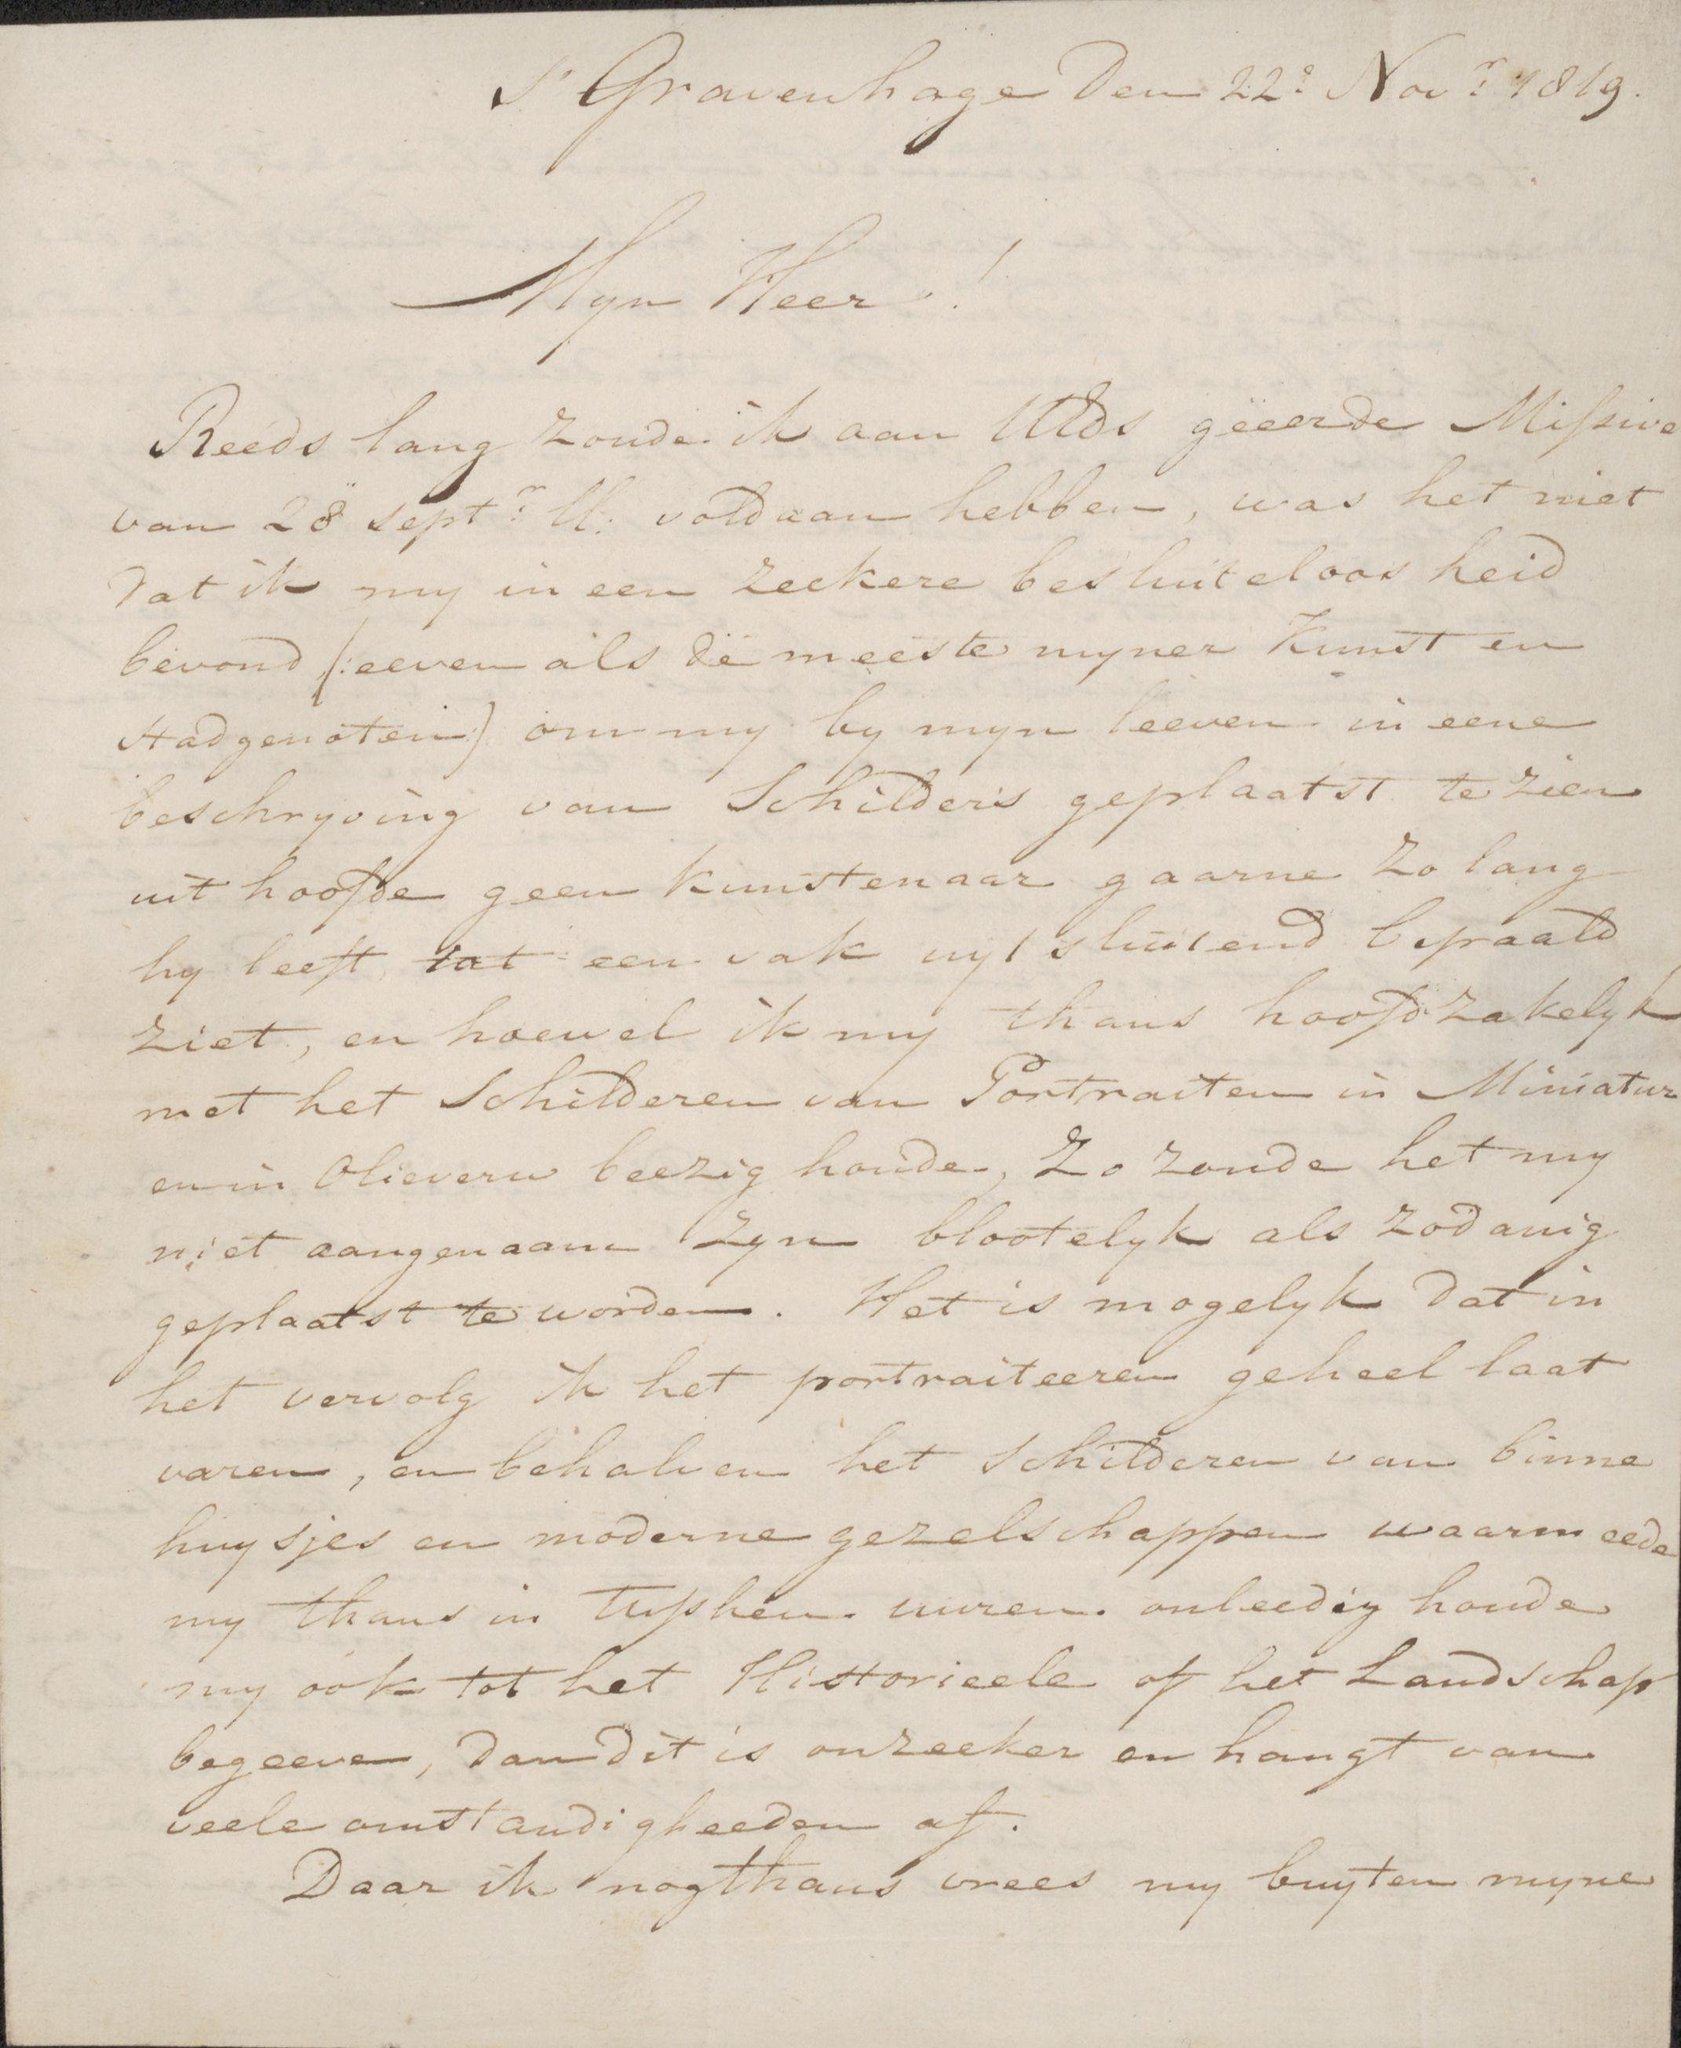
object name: letter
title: Brief aan Adriaan van der Willigen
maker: johannes hari (i)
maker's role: draughtsman, painter, print maker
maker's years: 1772-1849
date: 1819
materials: ink, paper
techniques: pen, writing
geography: the hague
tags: rotterdam, haarlem, draughtsman, adriaan van der willigen, jean george teissier, schools, anonymous historical person portrayed, education, tuition of the artist (in general), painting (including book-illumination, miniature-painting)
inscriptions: watermark